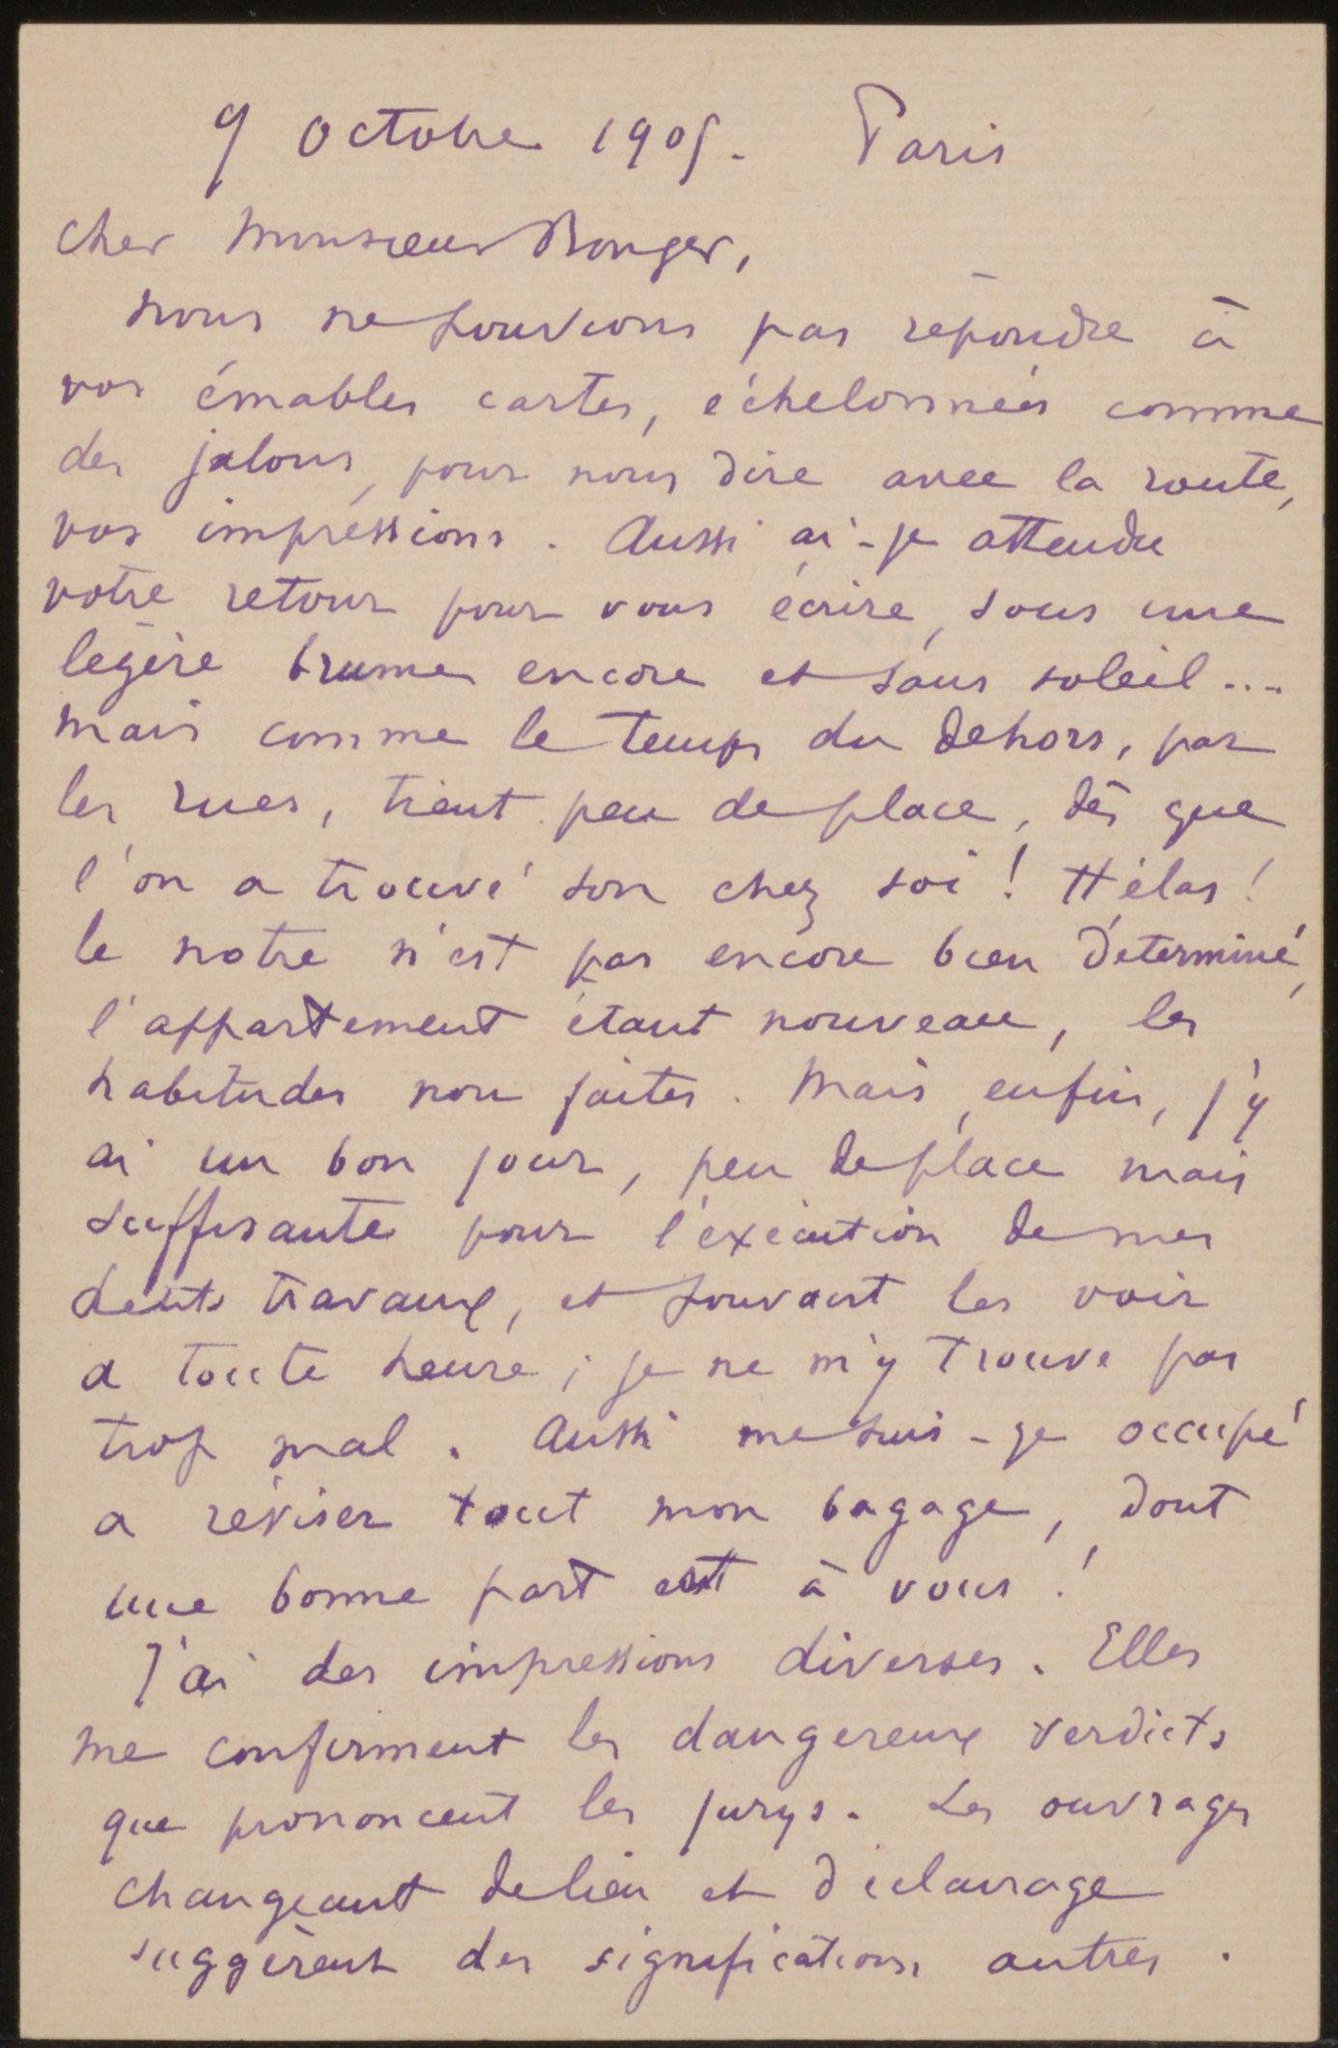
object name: letter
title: Brief aan Andries Bonger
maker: odilon redon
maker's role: draughtsman, painter, print maker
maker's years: 1840-1916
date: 1905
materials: ink, paper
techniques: pen, writing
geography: paris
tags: jules alexandre saturnin claye, paris, print maker, draughtsman, eugène delacroix, andries bonger, drawing, applied arts, arts and crafts; industrial design, exhibition ~ art, historical persons (portraits and scenes from the life), money, printed matter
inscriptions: watermark